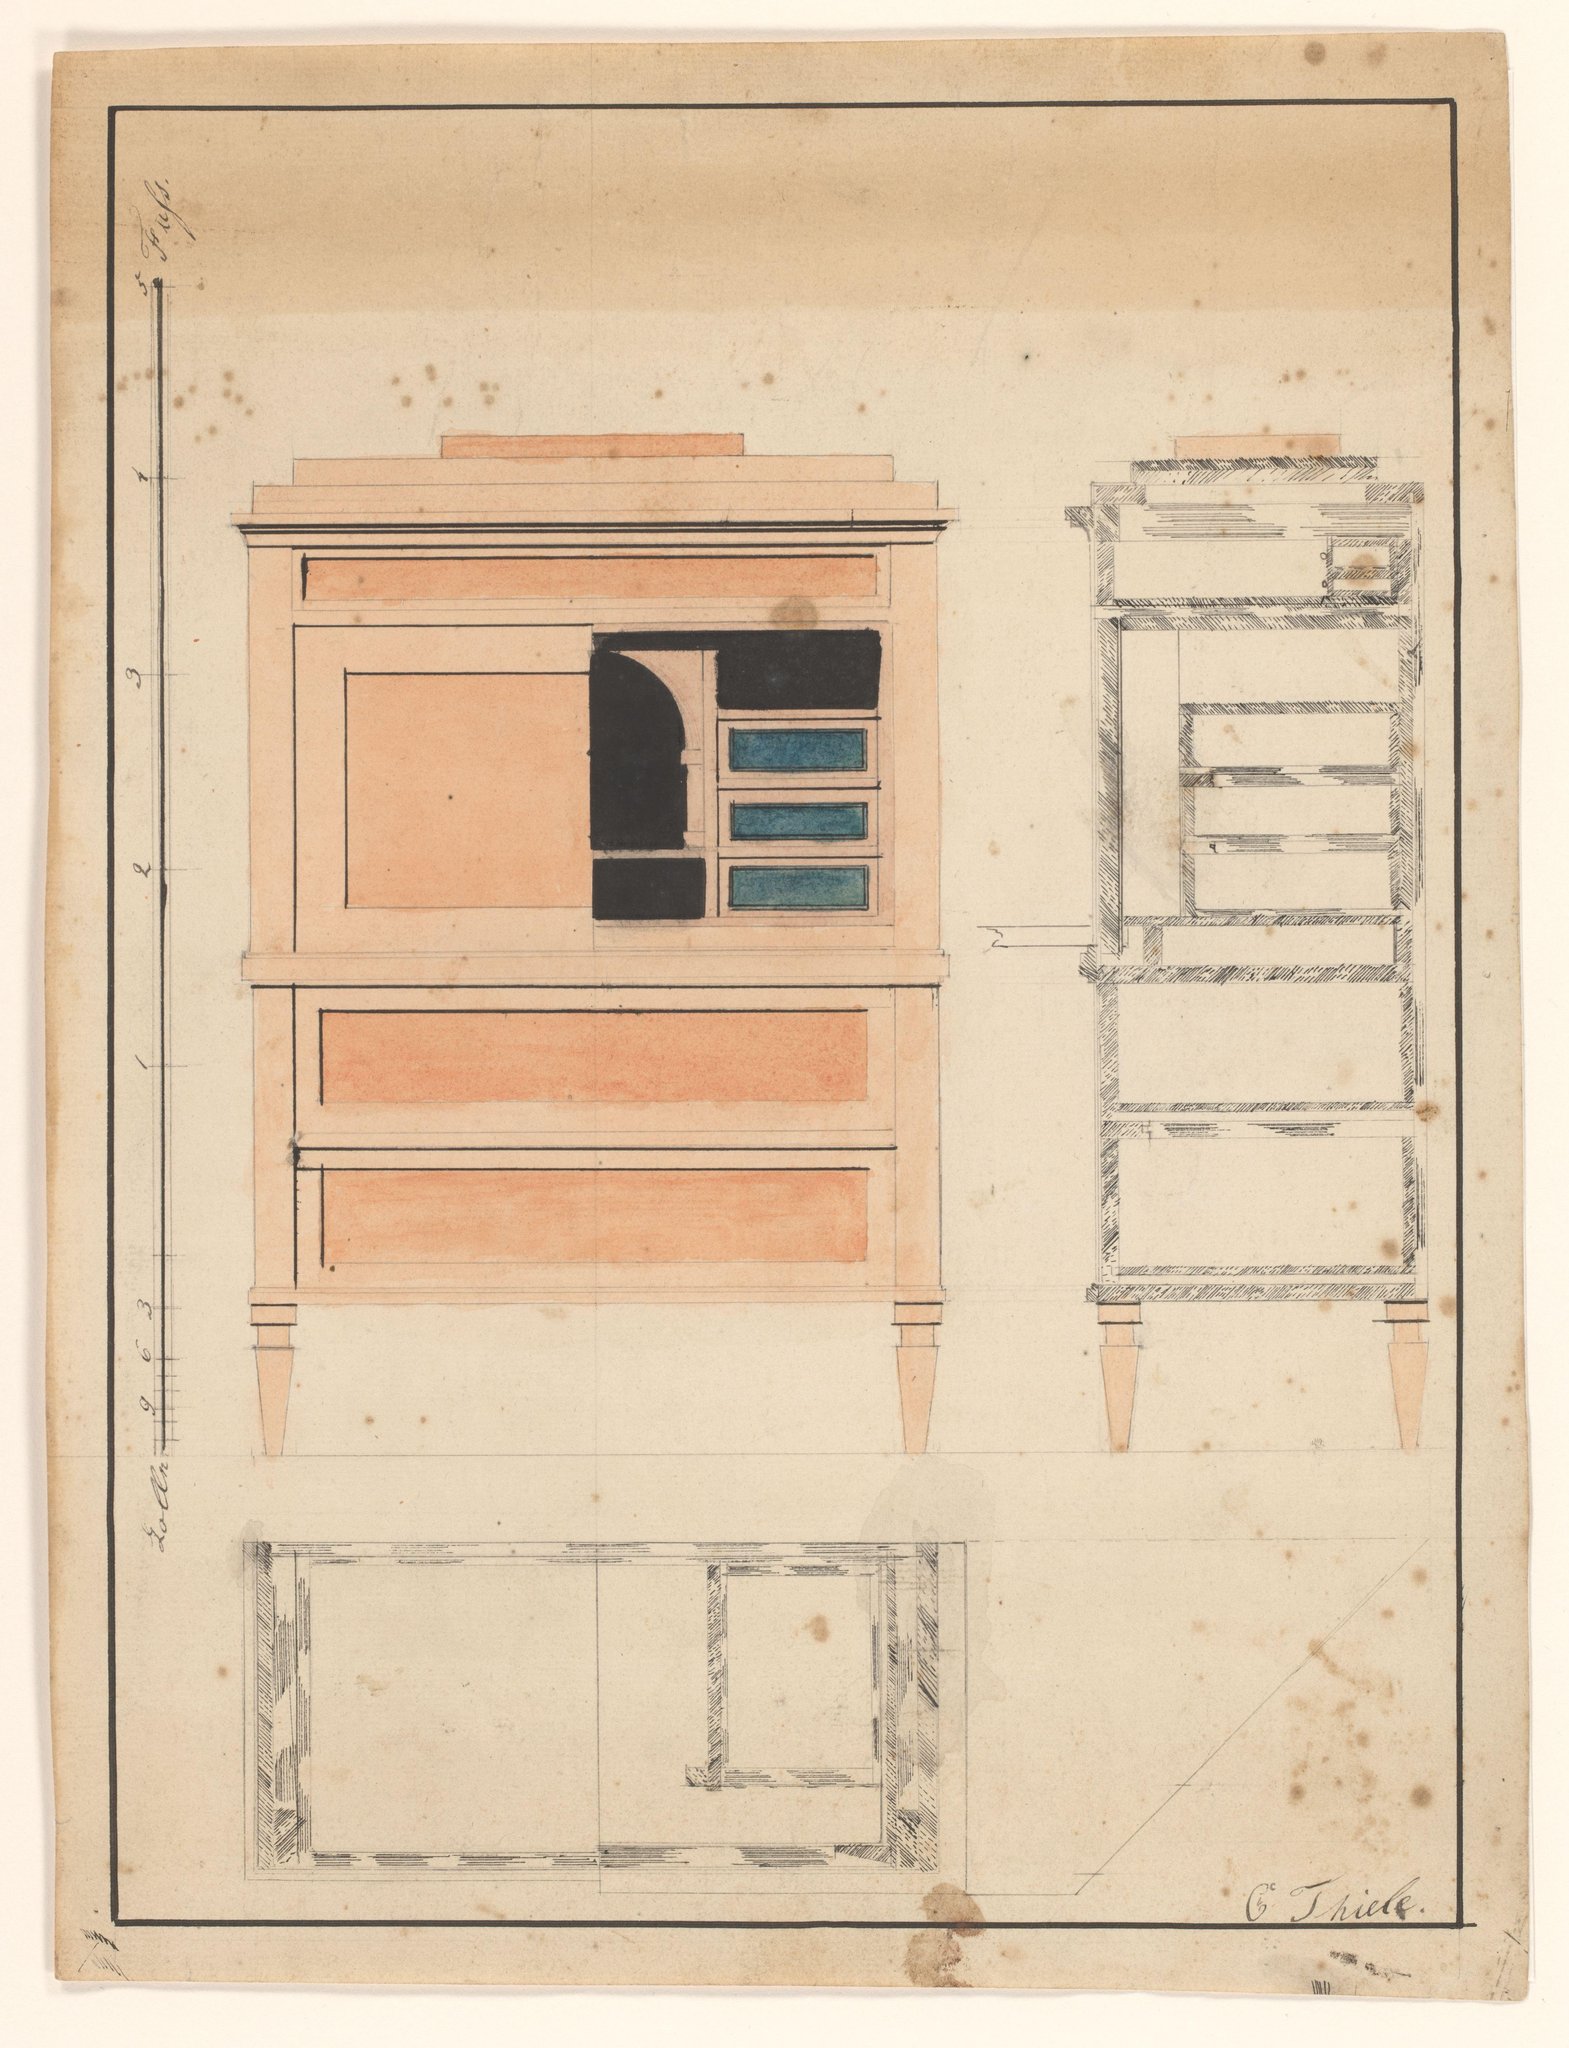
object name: design drawing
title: Ontwerp voor een secretaire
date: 1820-1825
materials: ink, paper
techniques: brush, pen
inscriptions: number: ‘2’, watermark, inscription: ‘Zoll 12 9 6 3 1 2 3 4 5 Fuss’, signature: ‘C. Thiele’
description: Getrapte opstand, voor- en zijaanzicht, met daaronder een in tweeën gedeelde plattegrond, links een maatverdeling.